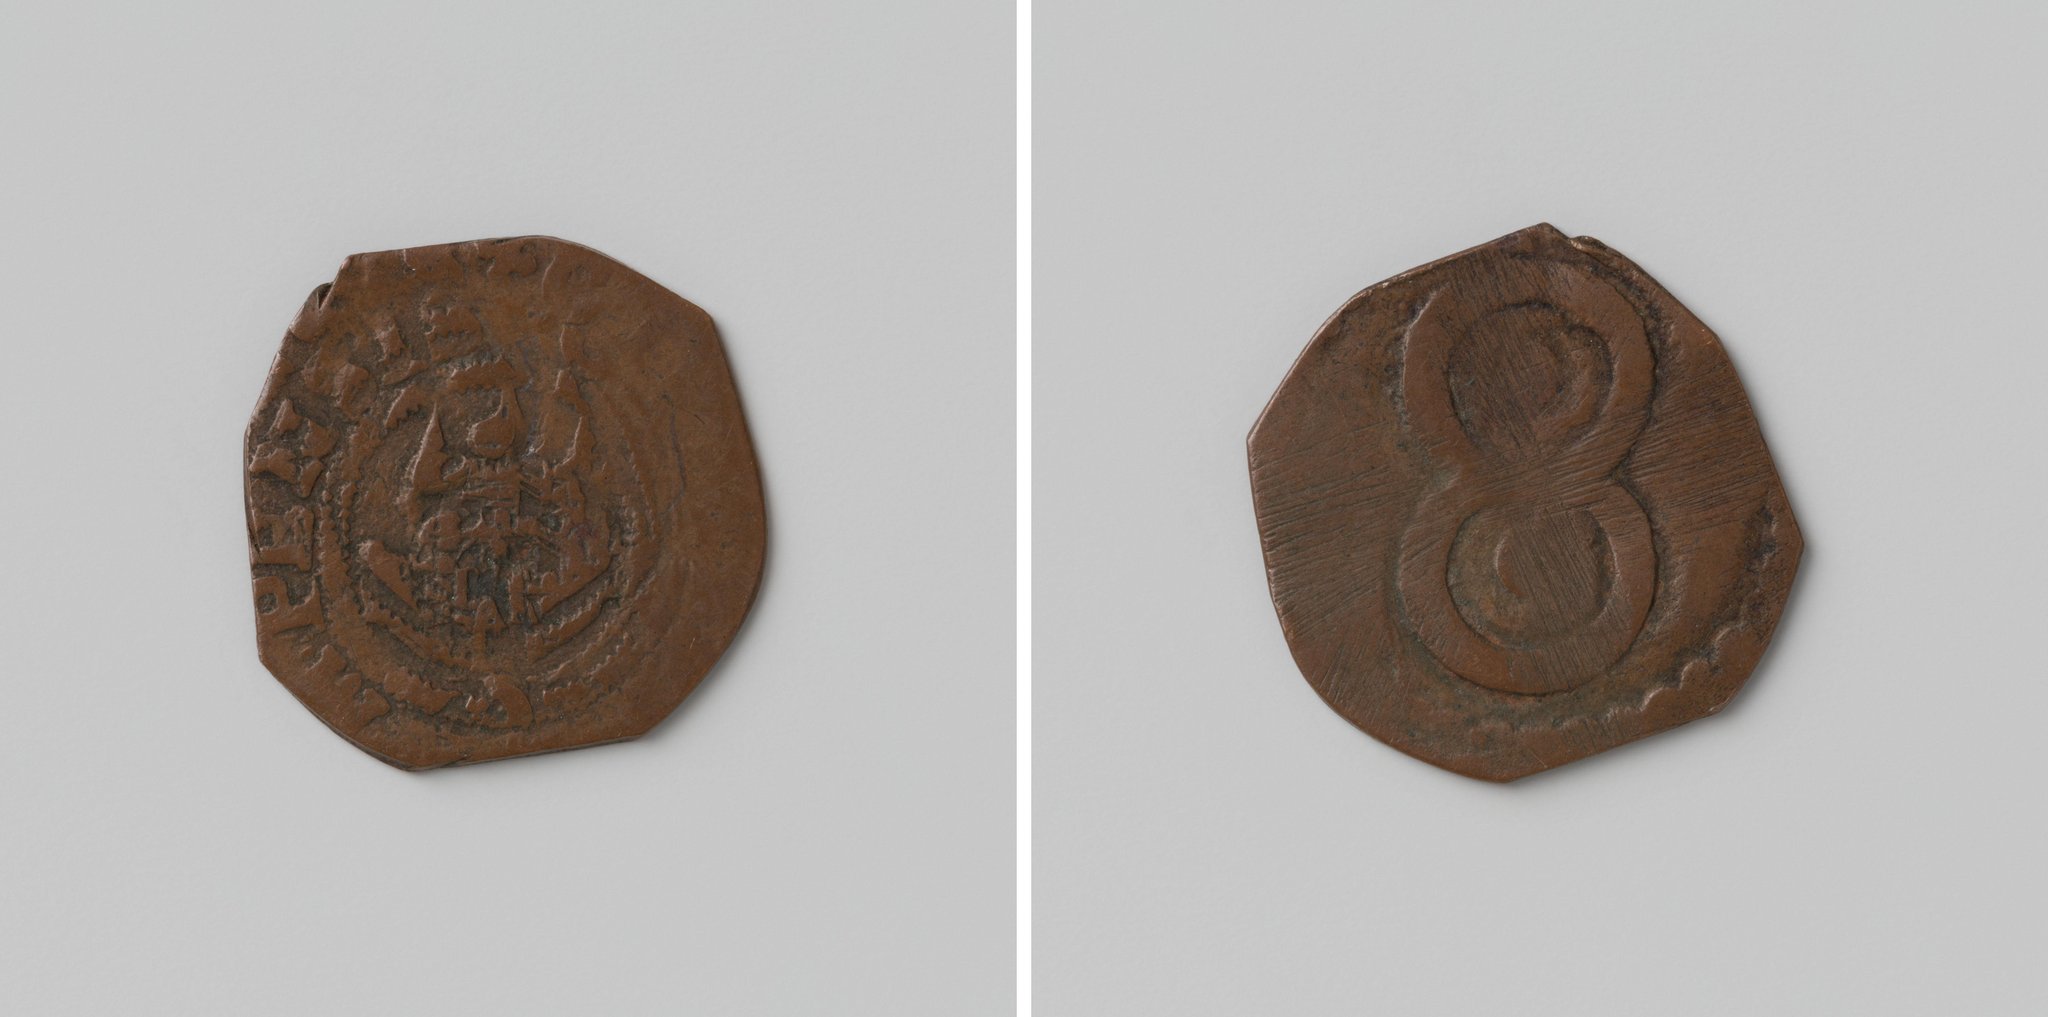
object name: bread token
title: Stad Kampen, loodje dat bij uitdeling recht gaf op brood of graan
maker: Anonymous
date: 1600-1800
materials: copper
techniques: striking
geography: kampen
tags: kampen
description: Koperen onregelmatig geknipt loodje. Voorzijde: in ronde stempel: burcht binnen omschrift. Keerzijde: cijfer 8 binnen sierrand.